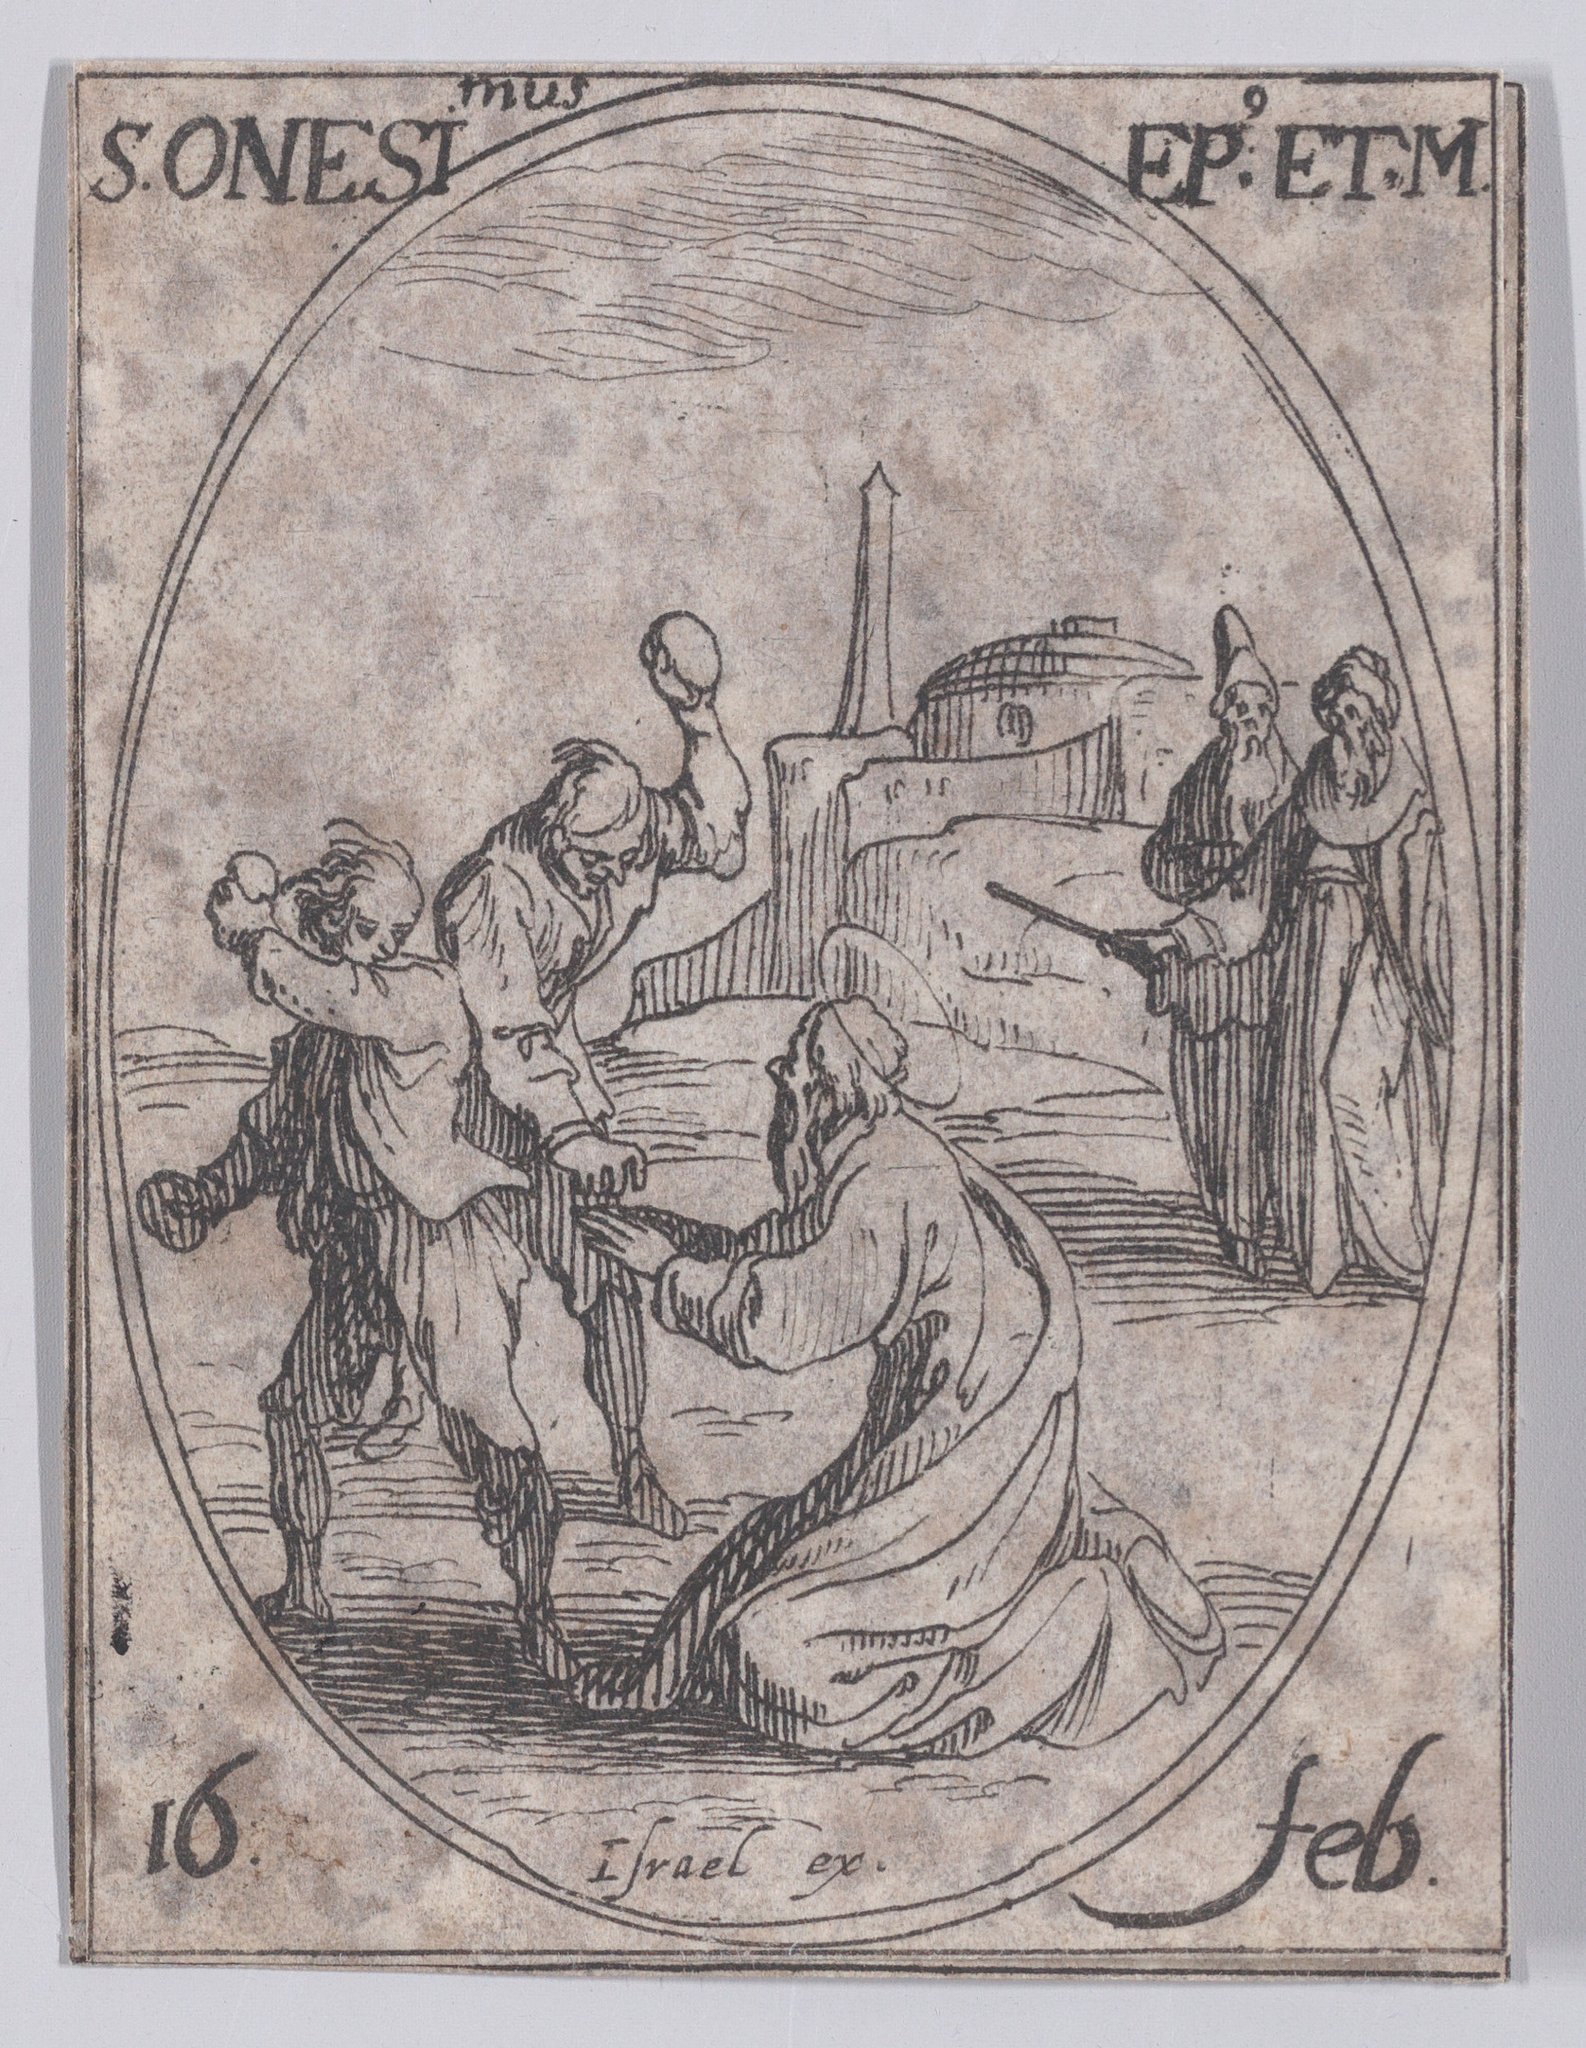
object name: print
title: S. Onésime, évêque et martyr (St. Onesimus, Bishop and Martyr), February 16th, from "Les Images De Tous Les Saincts et Saintes de L'Année" (Images of All of the Saints and Religious Events of the Year)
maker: jacques callot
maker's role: artist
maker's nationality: french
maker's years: 1592-1635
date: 1636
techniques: etching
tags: men,saints